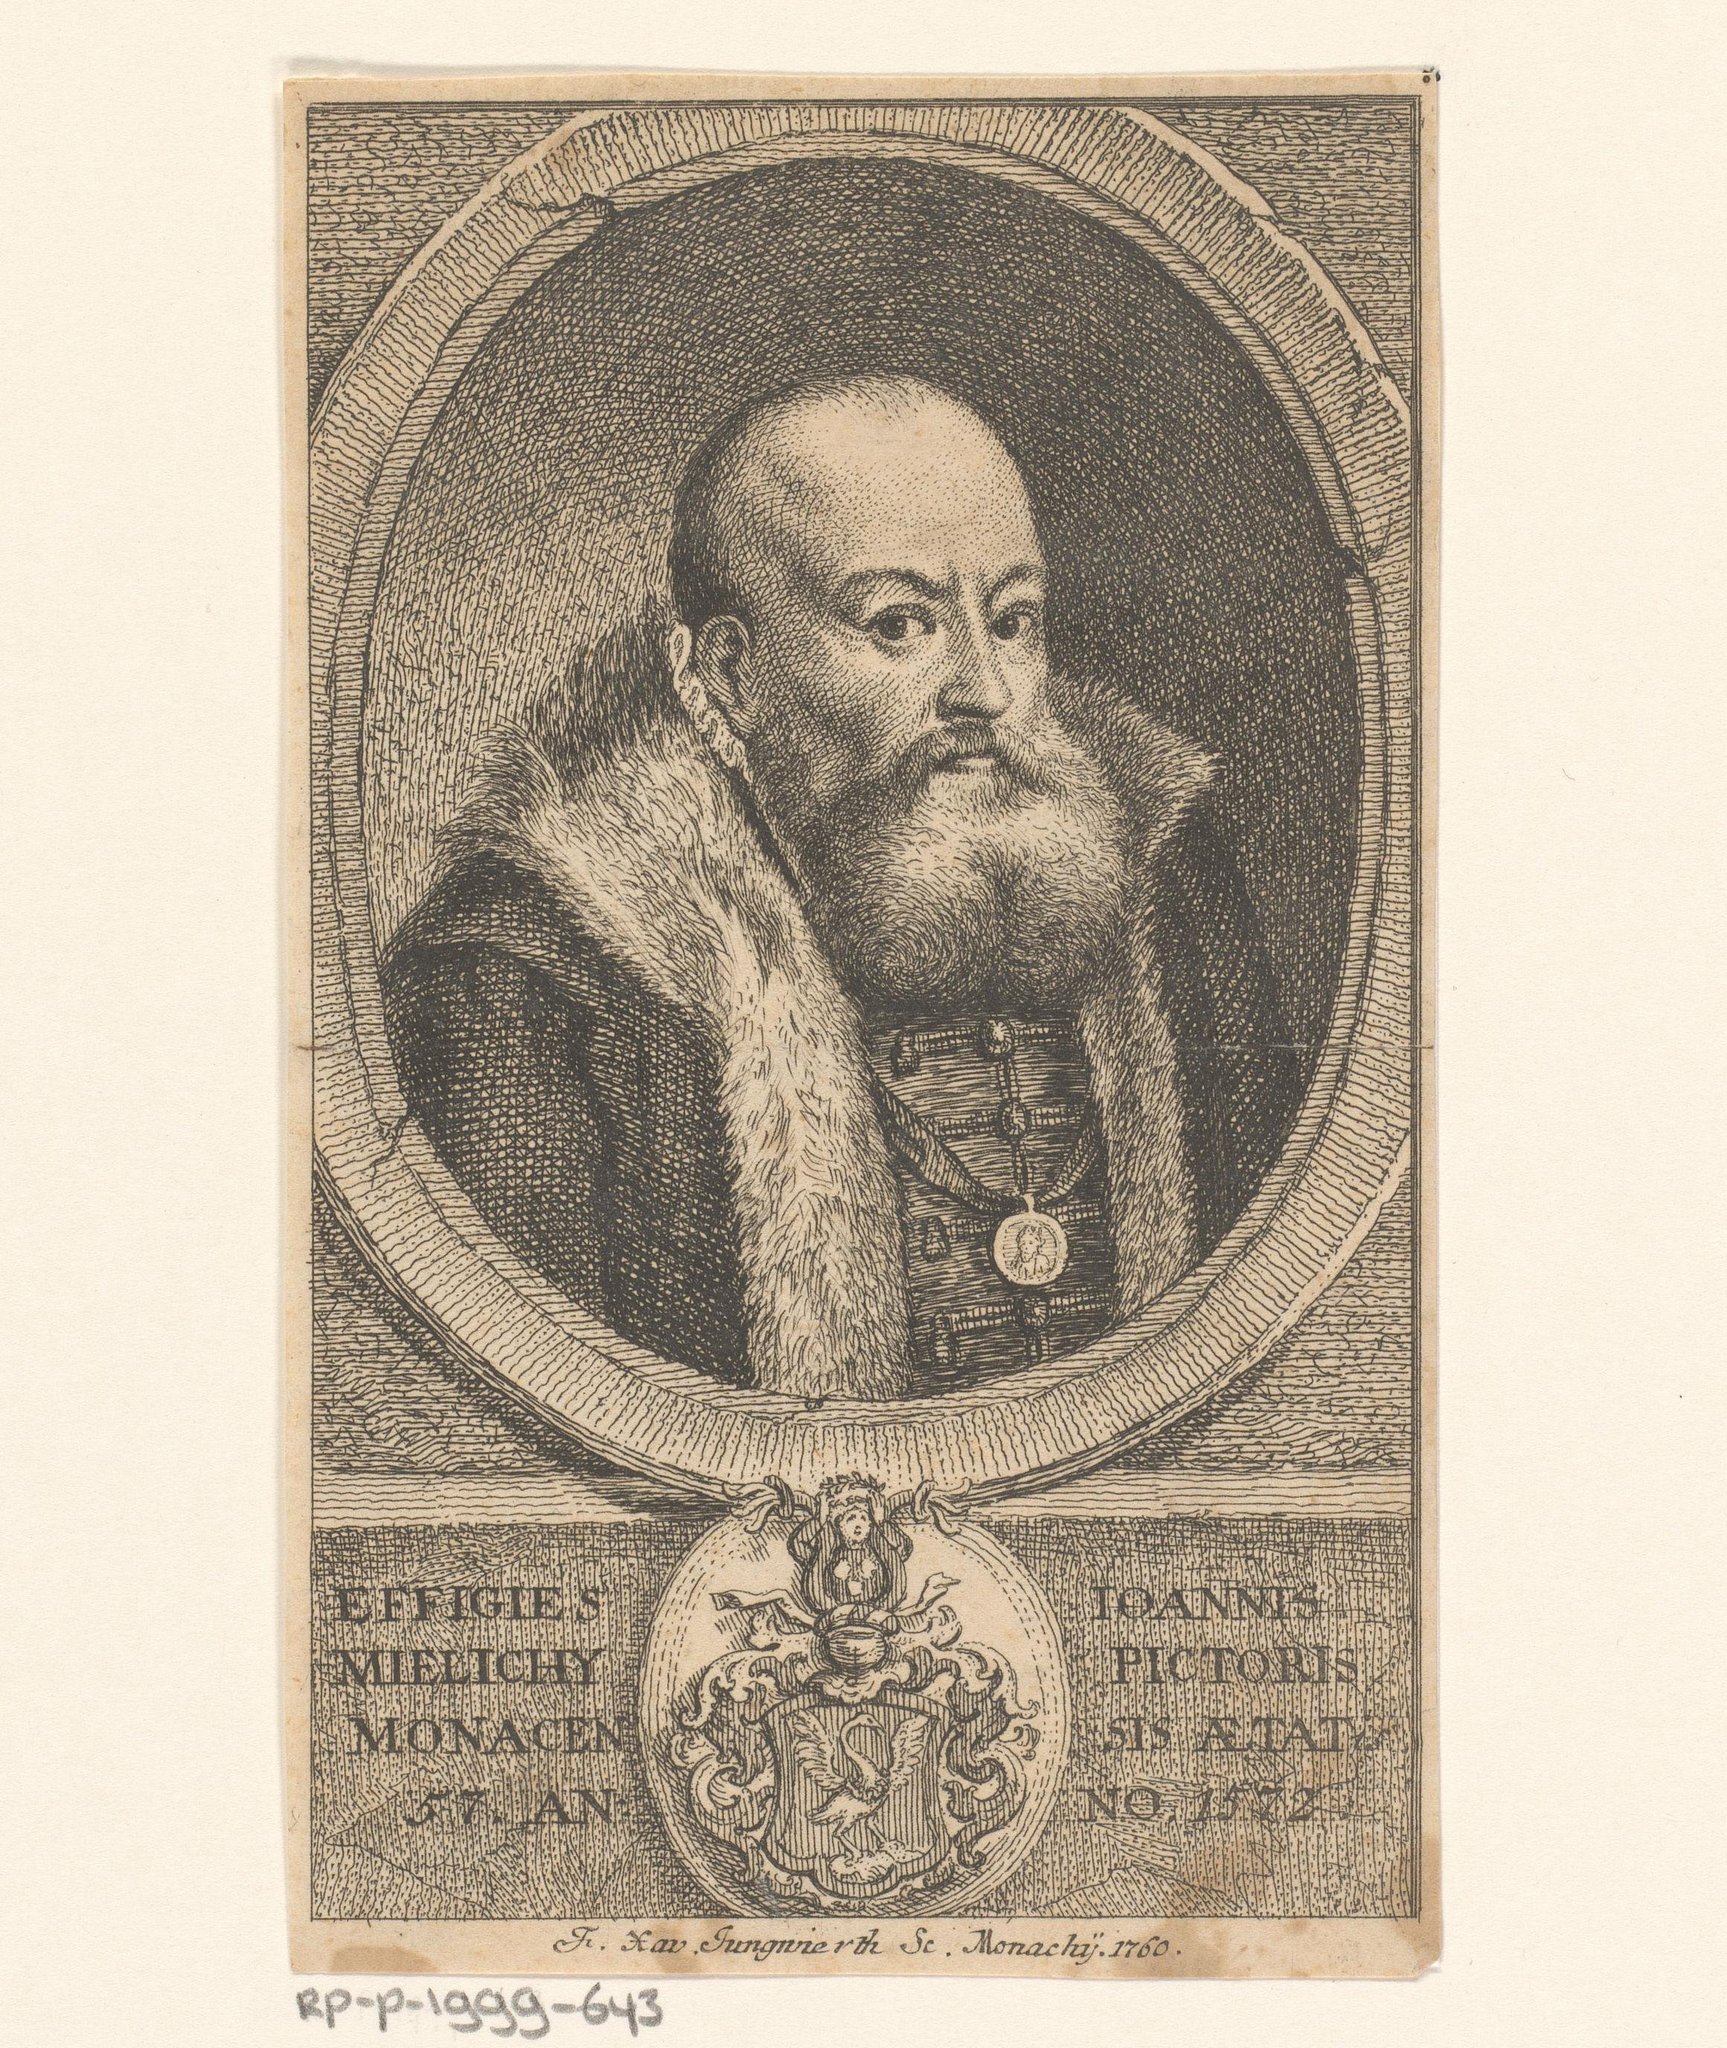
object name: print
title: Portret van Hans Mielich op 57-jarige leeftijd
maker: franz xaver jungwirth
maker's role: print maker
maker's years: 1720-1790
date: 1760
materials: paper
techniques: etching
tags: hans mielich, historical persons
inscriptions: collector's mark: Lugt 2228, collector's mark: Lugt 2760, collector's mark: Lugt 4100, collector's mark: Lugt 1238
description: Hans Mielich (1516-1573), Duits schilder, vooral bekend om zijn portretten, miniaturen en boekverluchting. Buste naar rechts, in mantel met brede bontrand, penning aan een lint op de borst. Familiewapen middenonder.